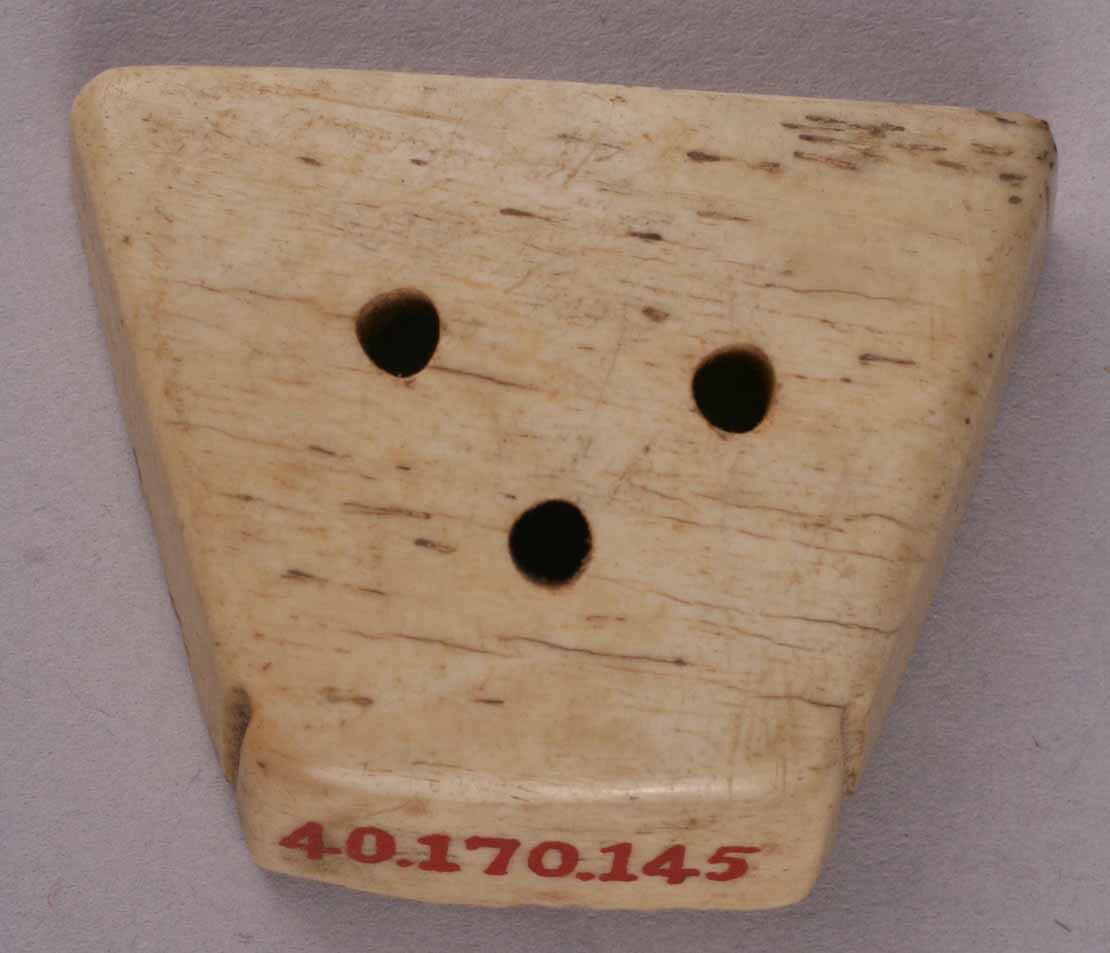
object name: ornament plaque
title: Ornament or Plaque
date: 801-1000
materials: bone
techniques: cutting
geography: iran